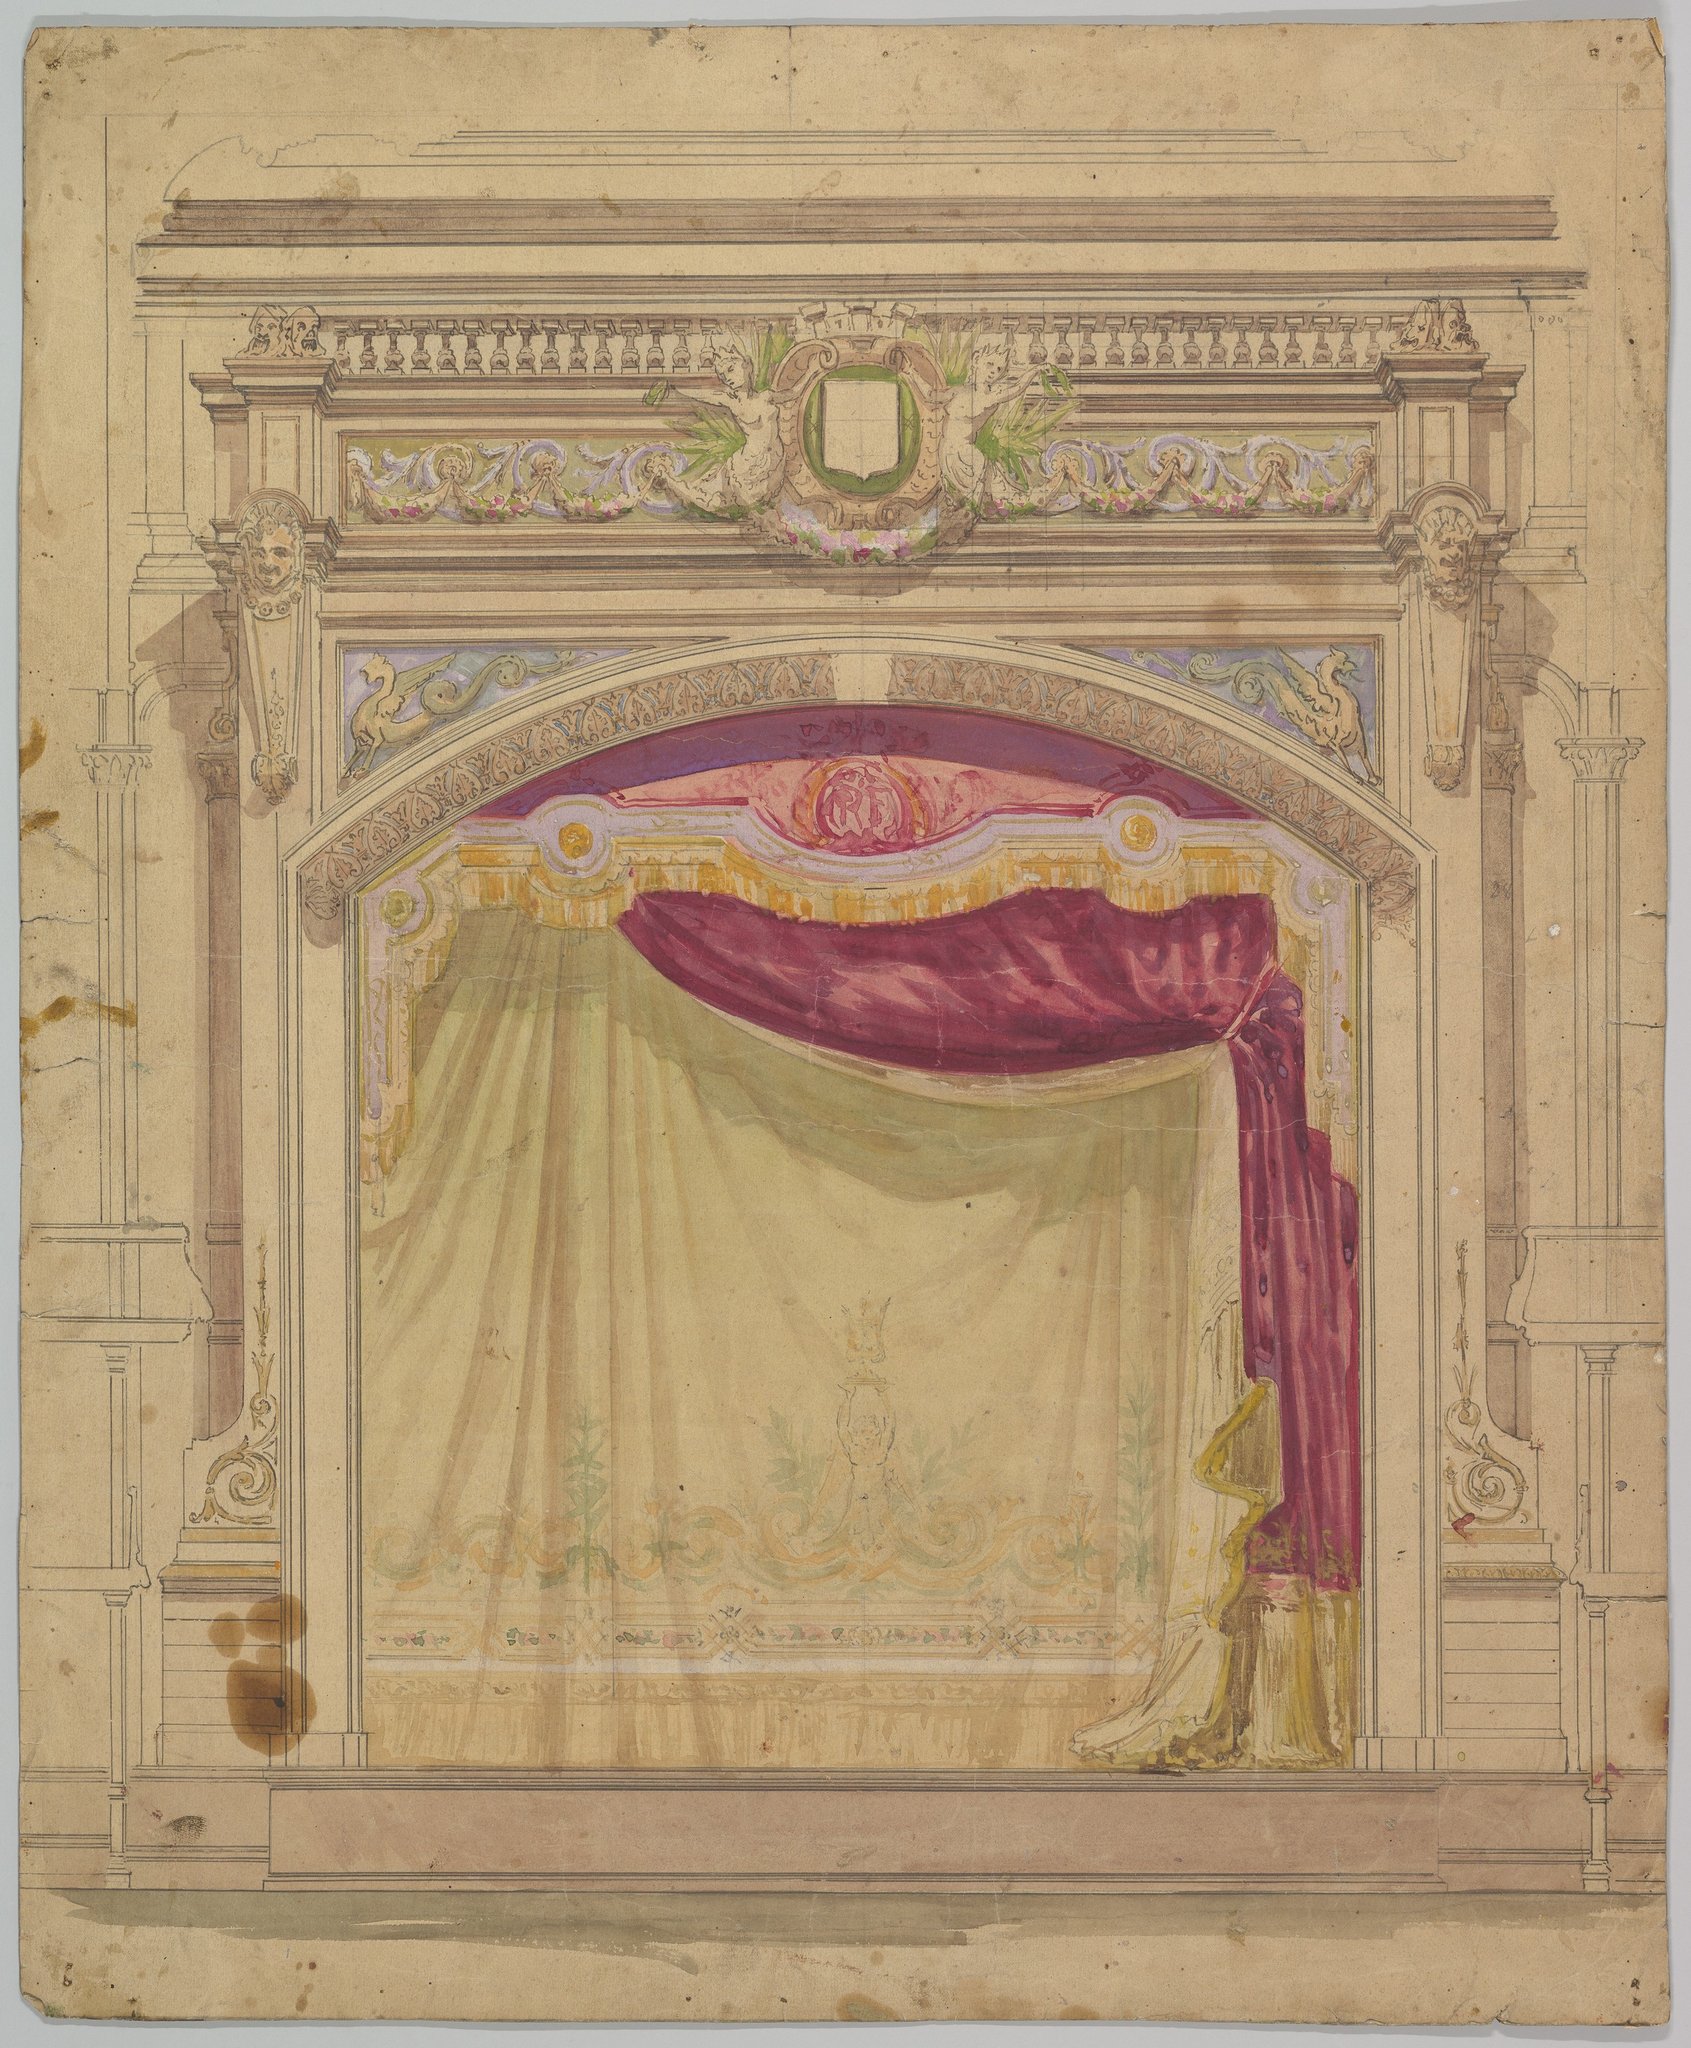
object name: drawing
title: Design for a Stage Set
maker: eugène cicéri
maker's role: artist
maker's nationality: french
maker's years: 1813-1890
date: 1830-1890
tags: theatre,stage design